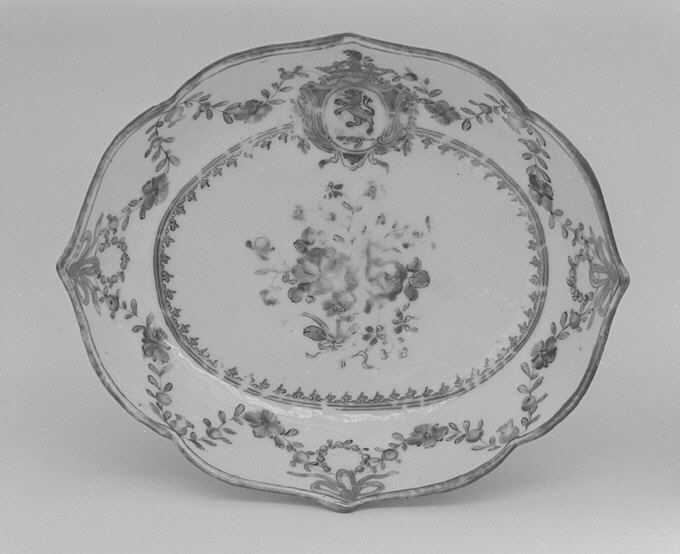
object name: dish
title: Bonbon dish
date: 1750-1770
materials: hard paste porcelain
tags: flowers,coat of arms